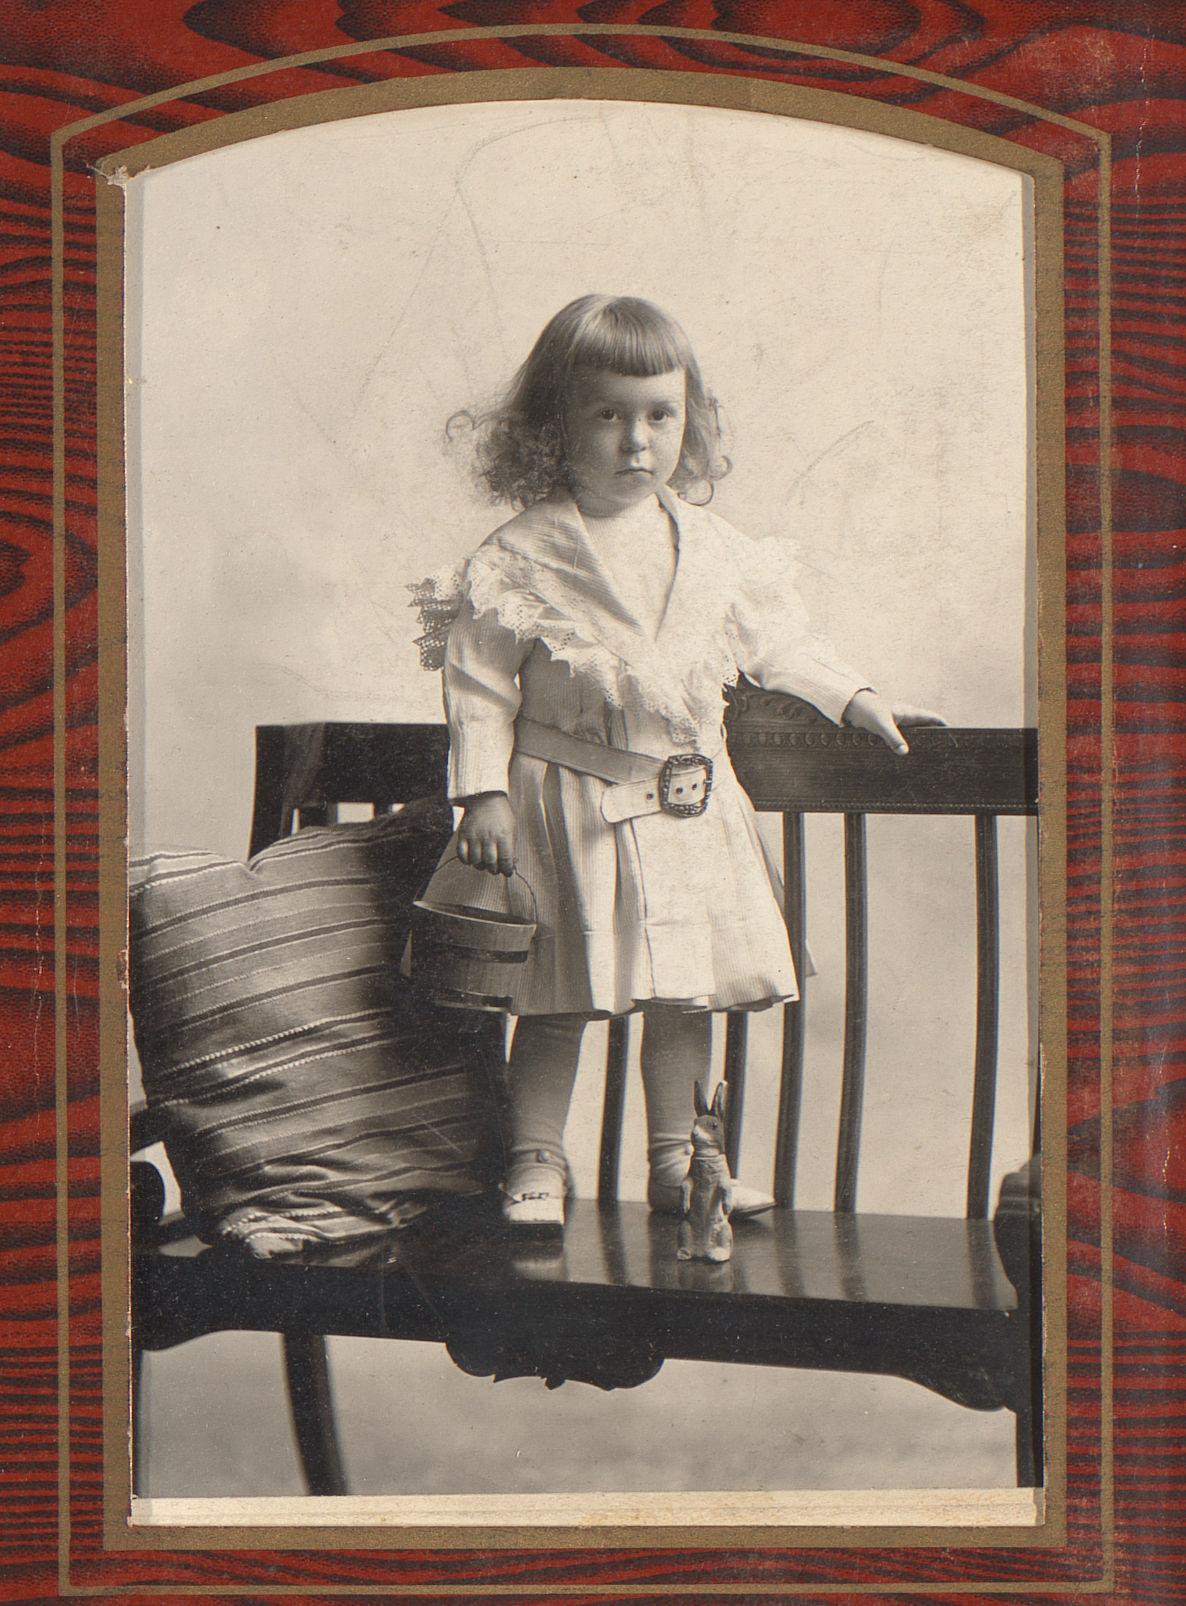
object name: photograph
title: Portret van een meisje, staand op een bank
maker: Anonymous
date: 1860-1920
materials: cardboard, photographic support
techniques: daylight paper print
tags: historical persons, girl (child between toddler and youth)